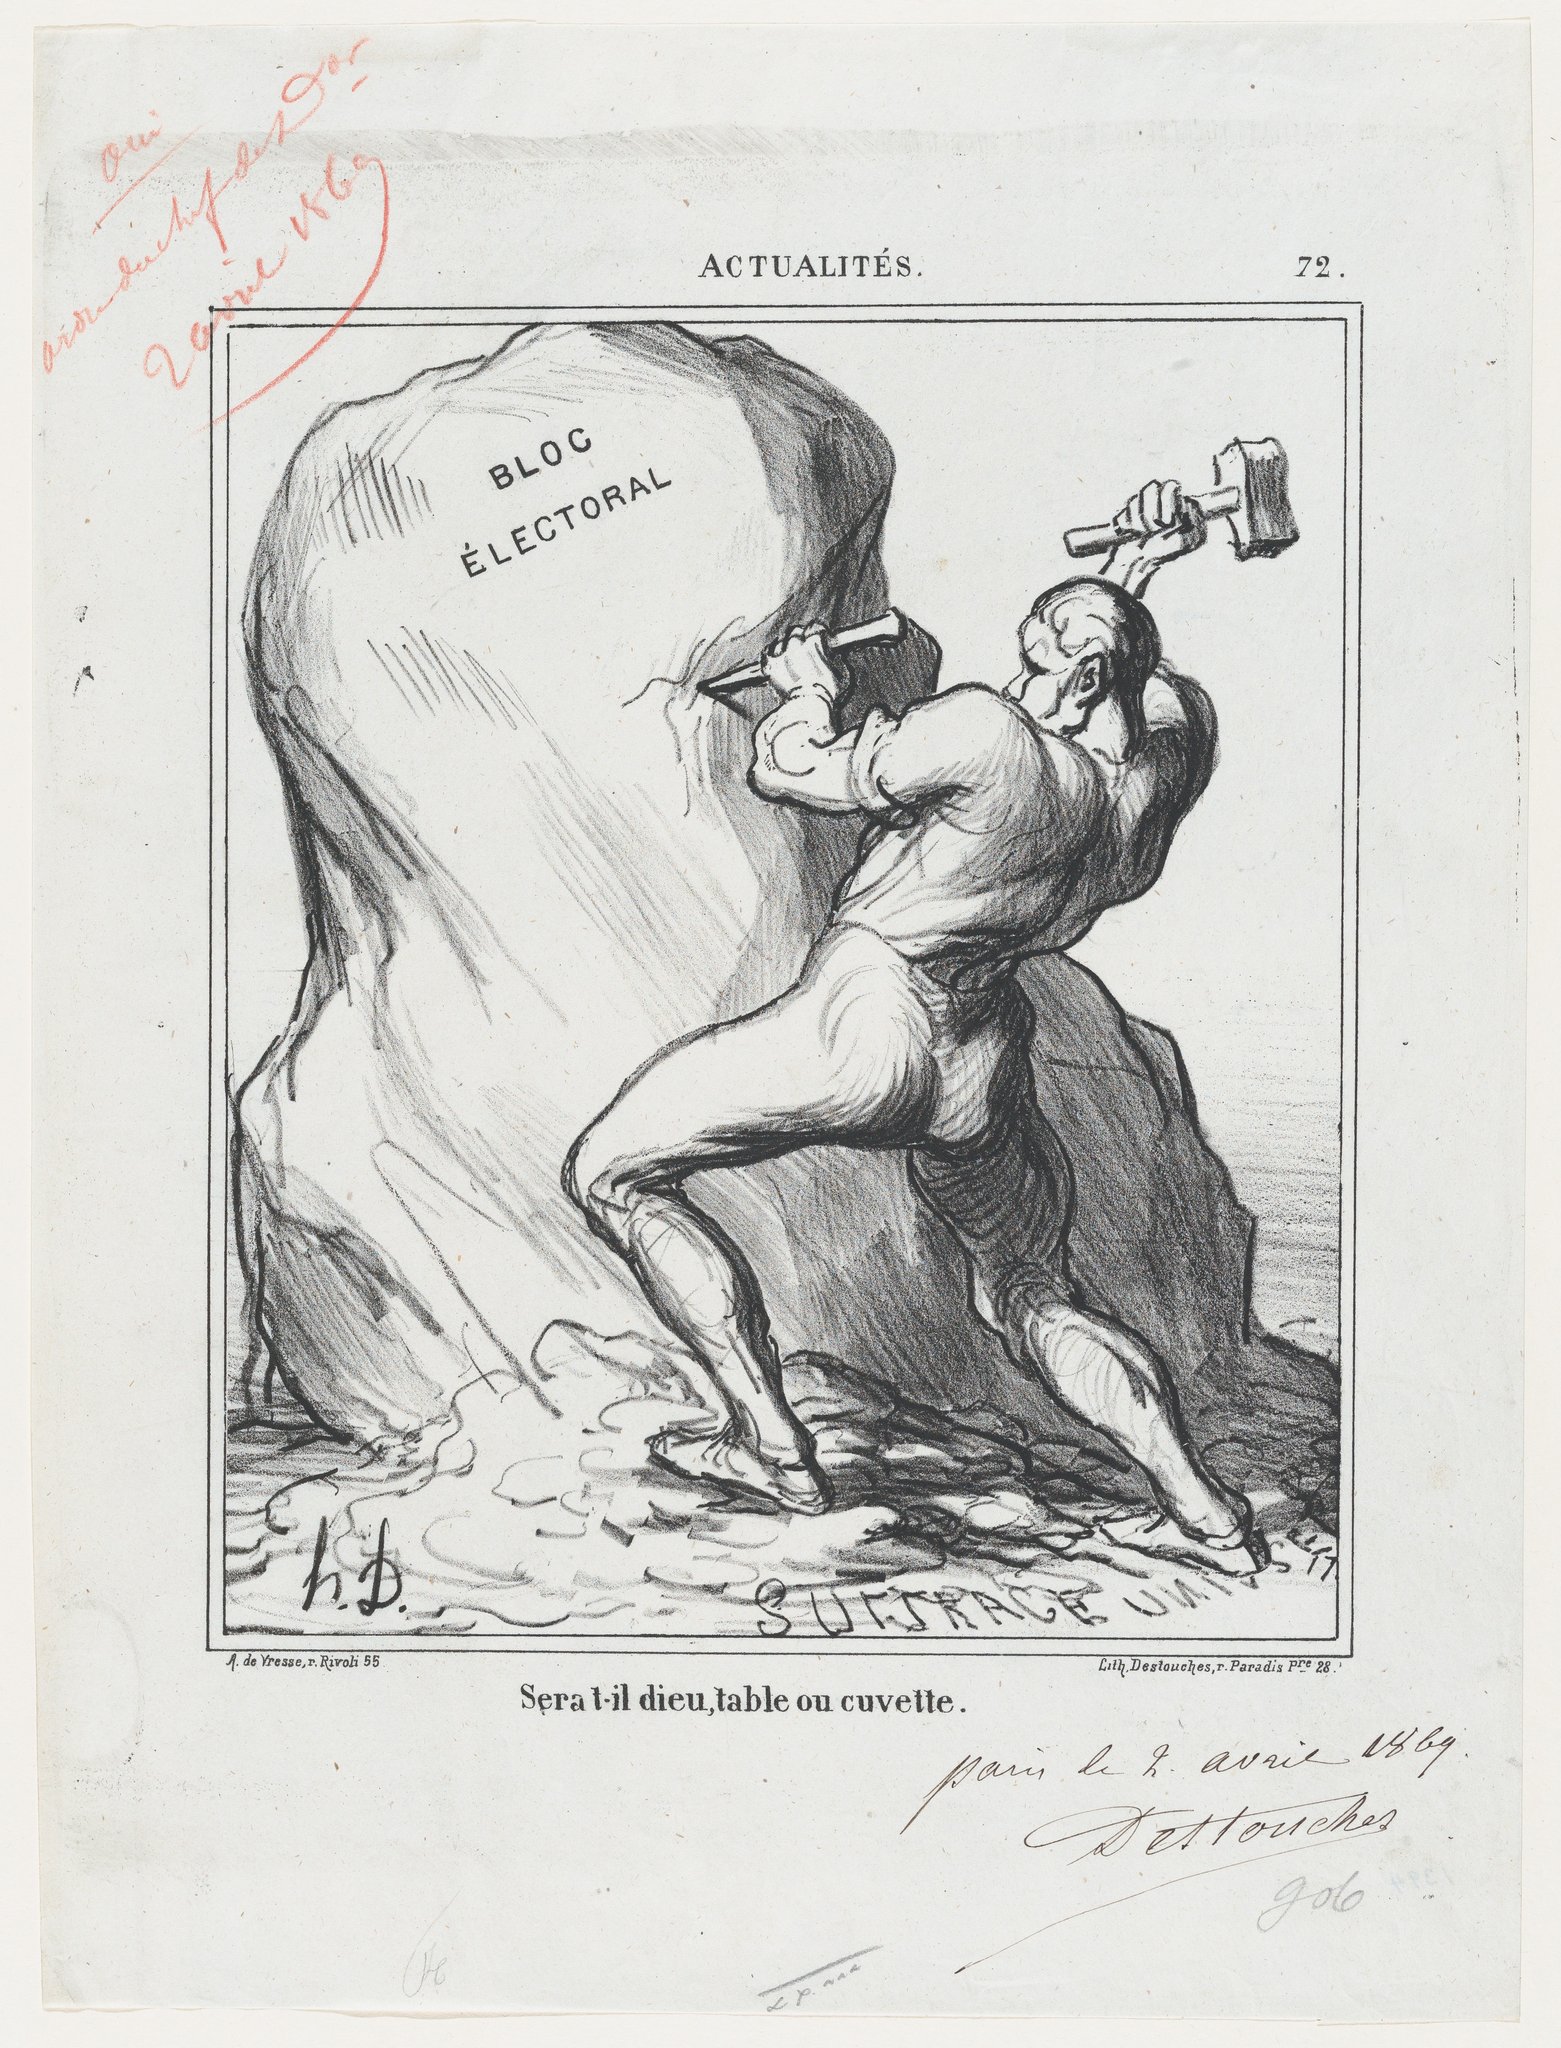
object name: print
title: Will he be God, a table, or a basin?, from 'News of the day,' published in Le Charivari, April 12, 1869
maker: honoré daumier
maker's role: artist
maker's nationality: french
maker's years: 1808-1879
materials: ink, paper, pencil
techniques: lithograph, pen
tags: men,working